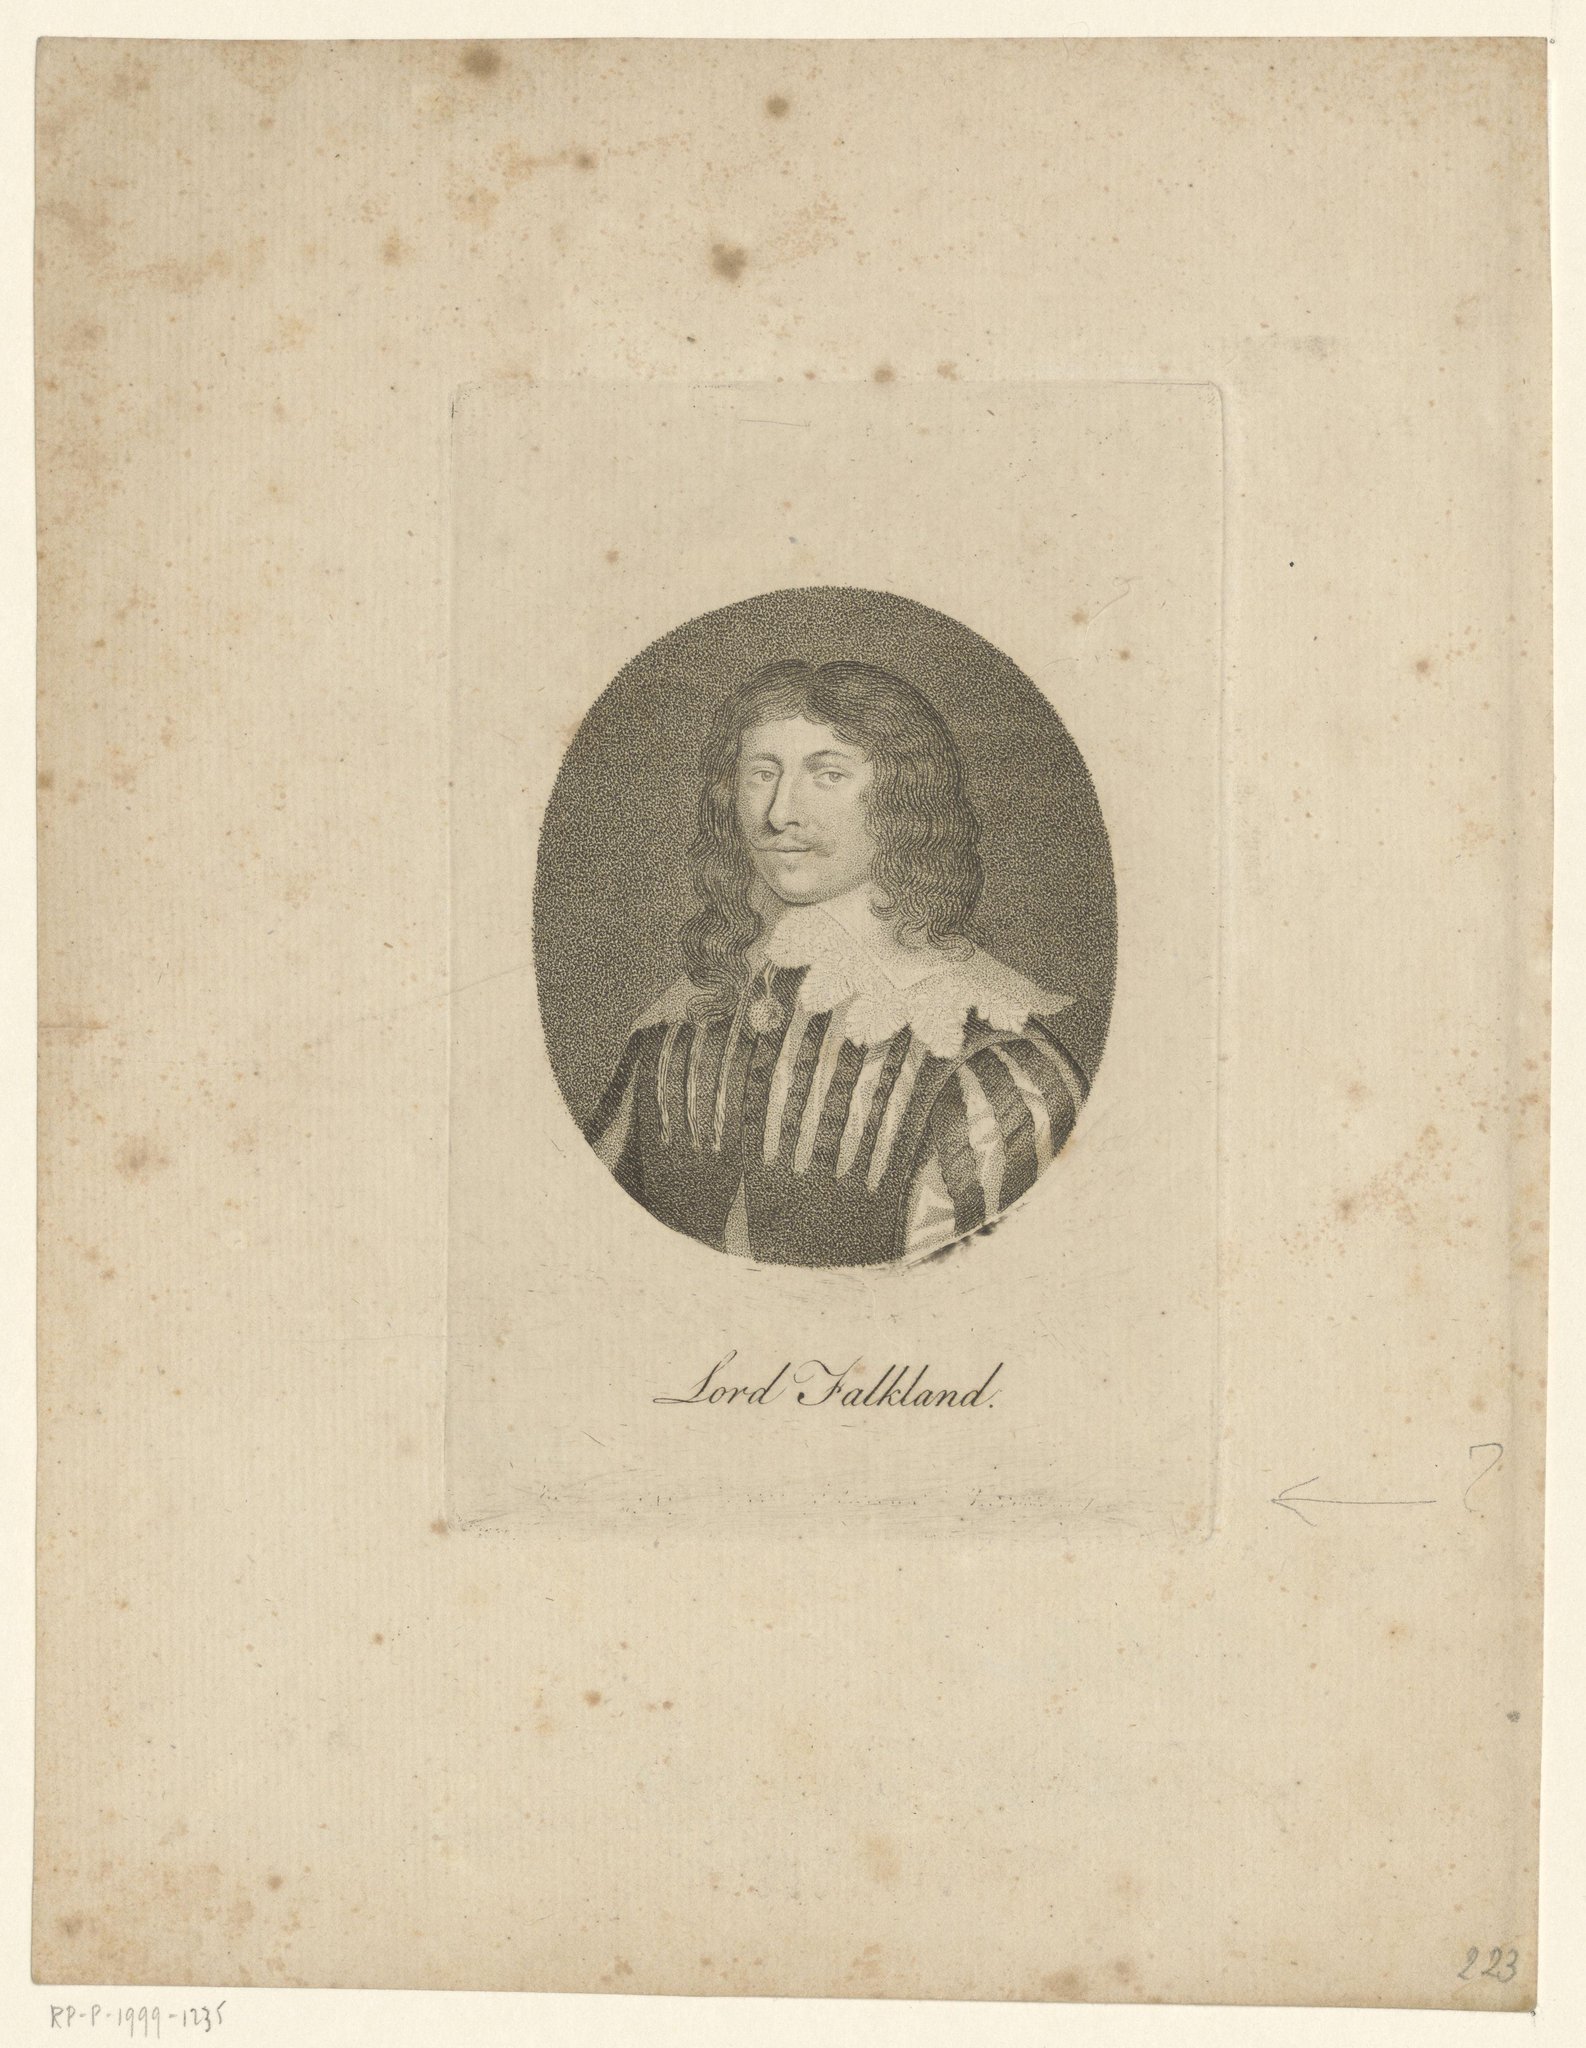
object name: print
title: Portret van Lucius Cary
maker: Anonymous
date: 1630-1700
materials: paper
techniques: etching, engraving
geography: england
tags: politician, historical persons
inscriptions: collector's mark: Lugt 2228, collector's mark: Lugt 2760